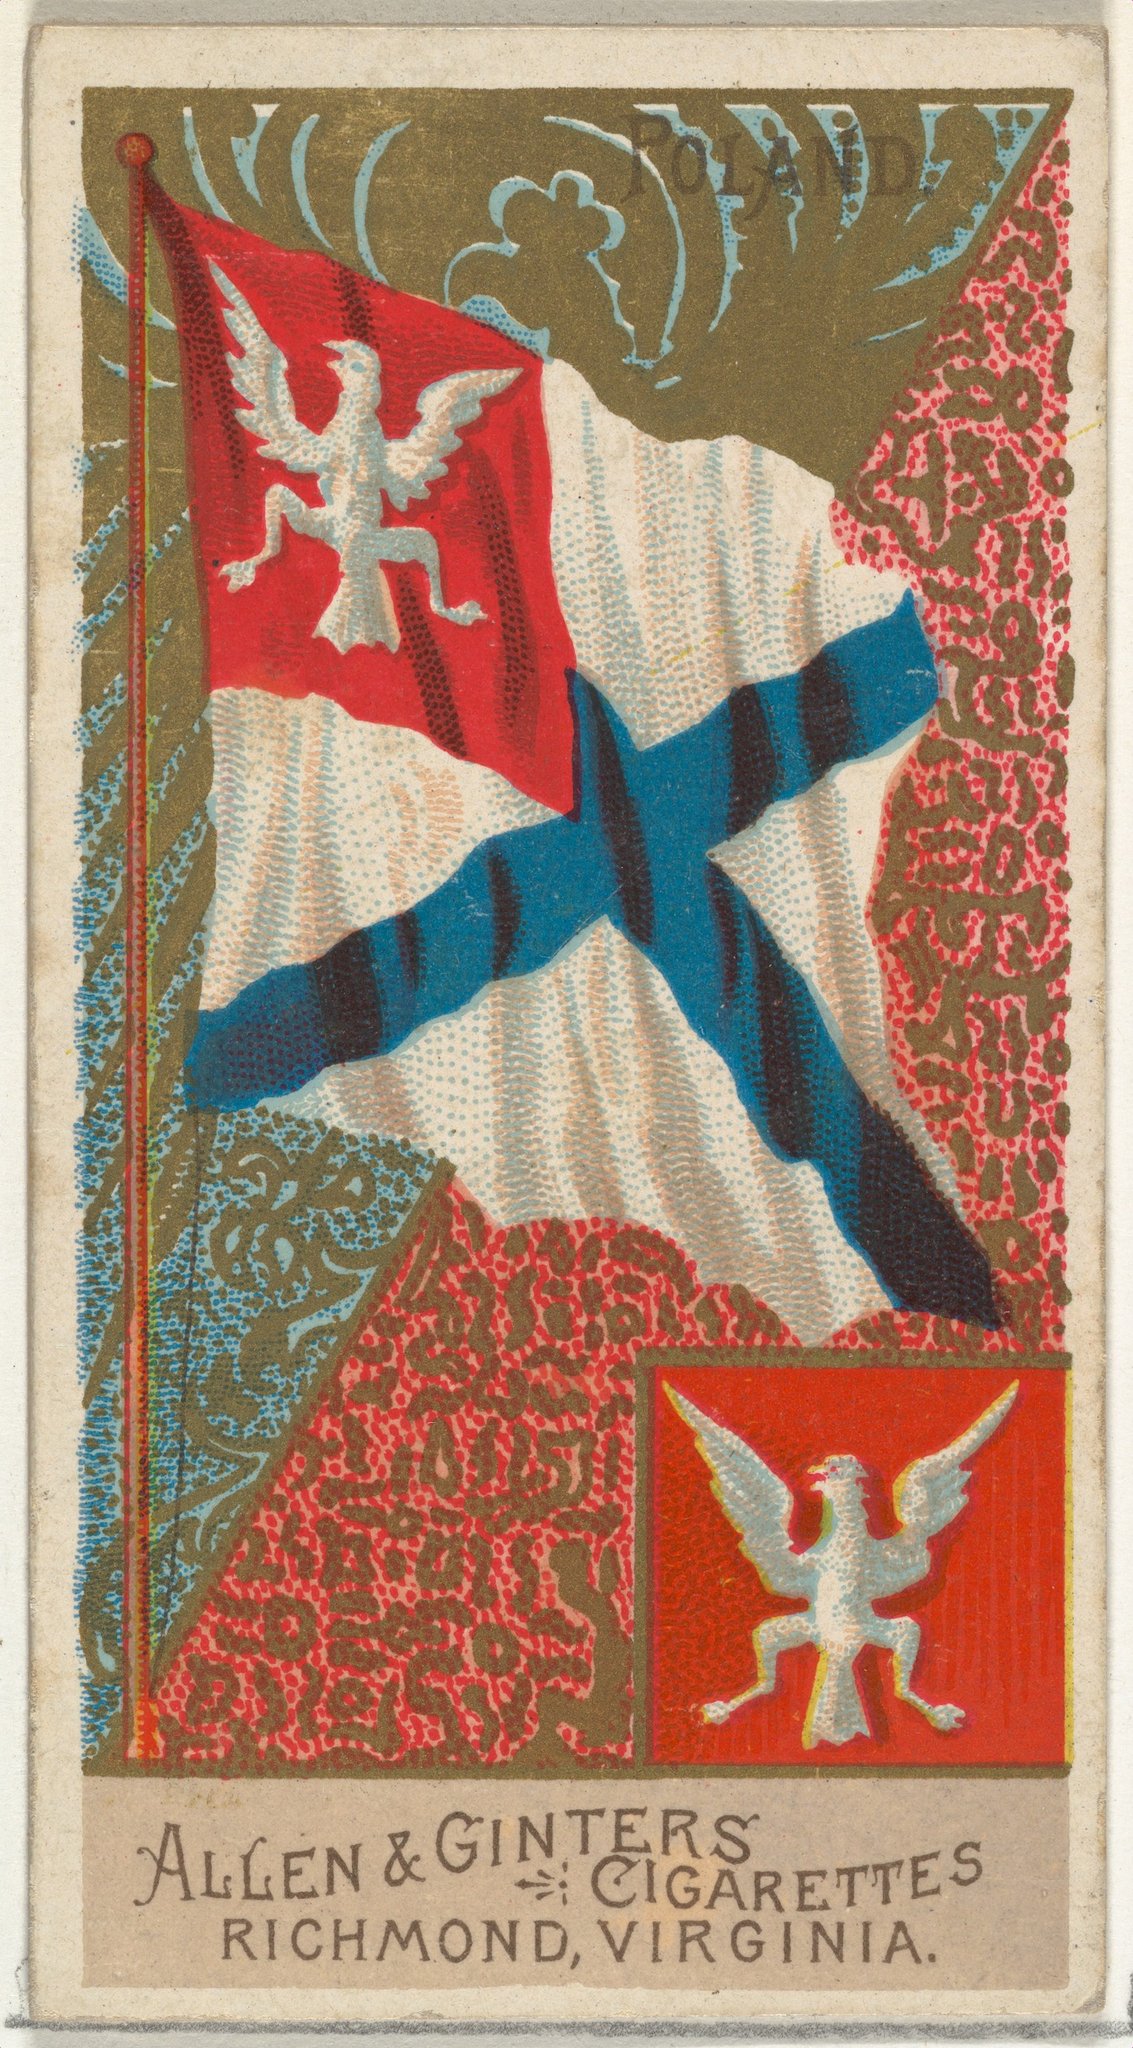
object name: print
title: Poland, from Flags of All Nations, Series 2 (N10) for Allen & Ginter Cigarettes Brands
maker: allen & ginter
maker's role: publisher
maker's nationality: american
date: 1890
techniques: color lithograph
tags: flags